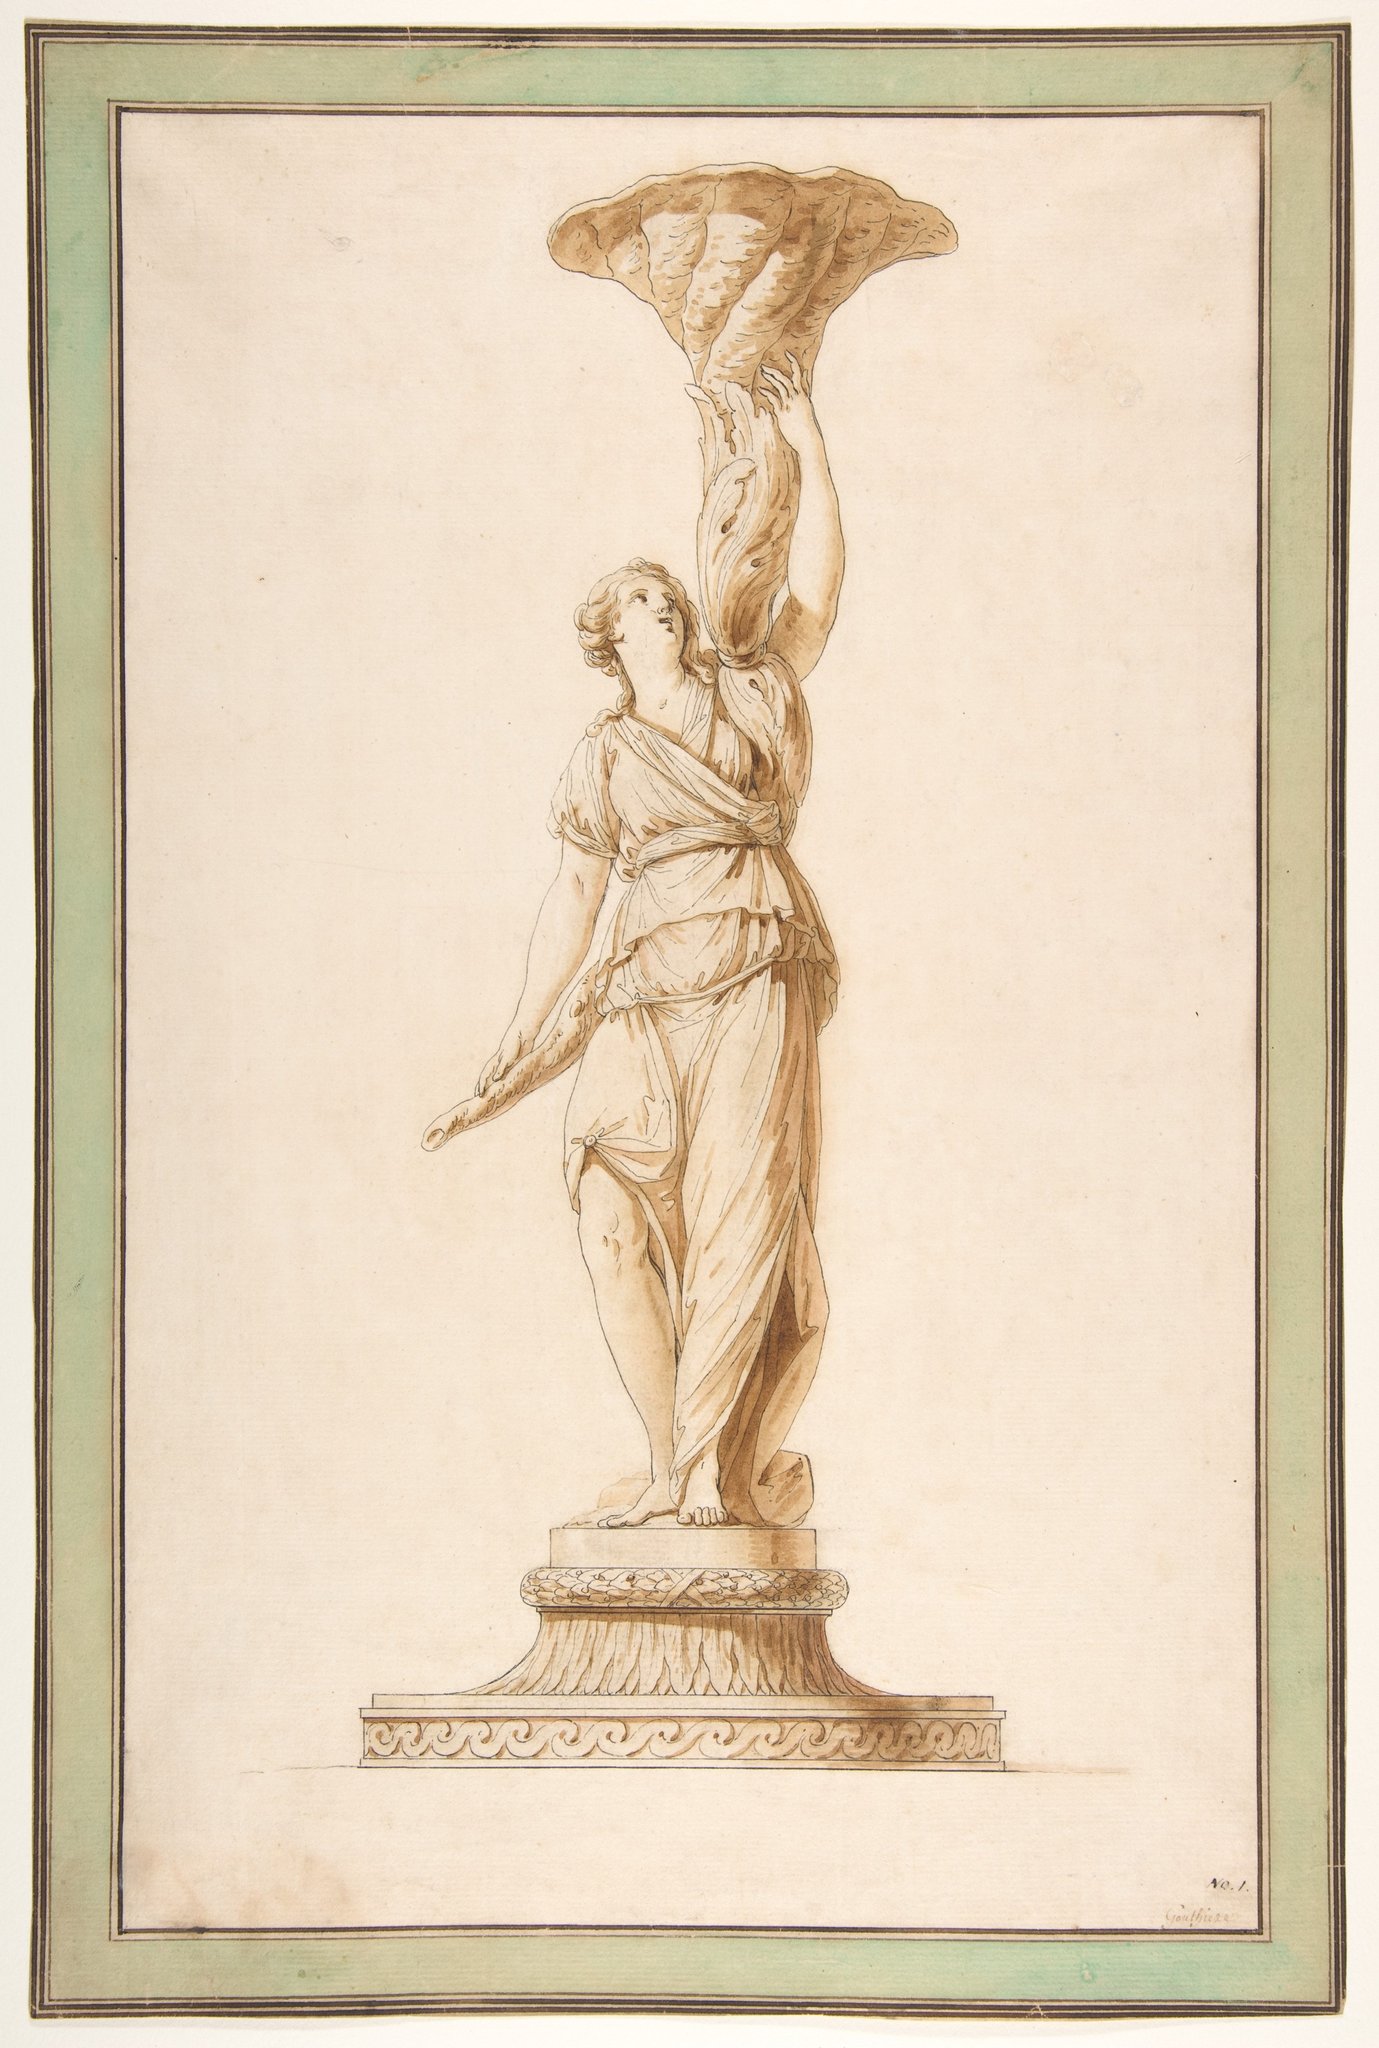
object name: drawing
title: Design for a Torchère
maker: jean jacques françois le barbier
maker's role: designer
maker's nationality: french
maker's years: 1738-1826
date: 1770-1790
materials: ink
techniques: brush, pen, wash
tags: women